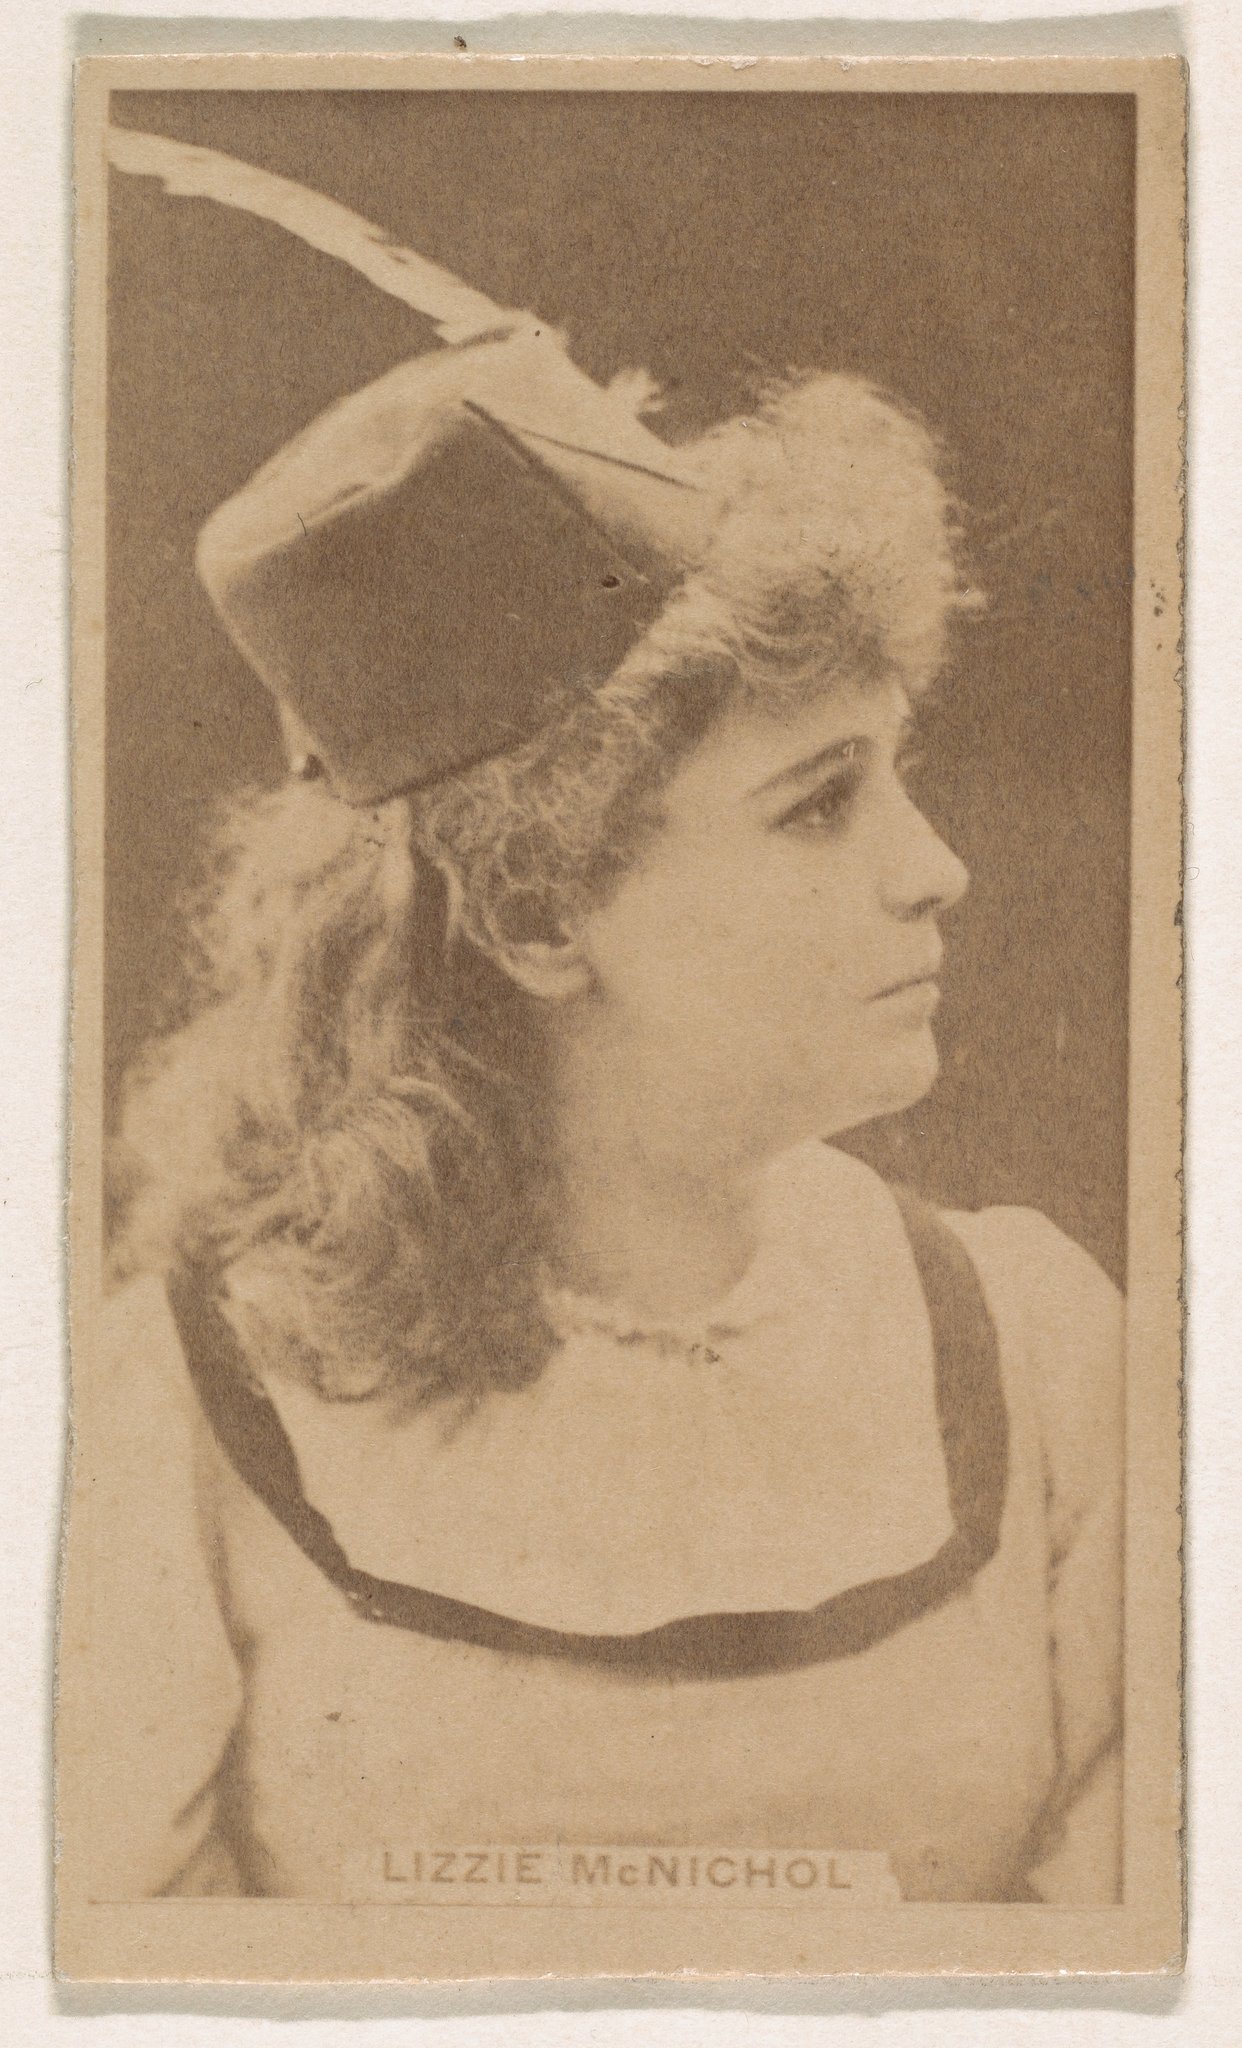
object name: photograph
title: Lizzie McNichol, from the Actresses series (N245) issued by Kinney Brothers to promote Sweet Caporal Cigarettes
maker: kinney brothers tobacco company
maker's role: publisher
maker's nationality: american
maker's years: 1869-2011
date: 1890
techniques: albumen silver print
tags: women,actresses